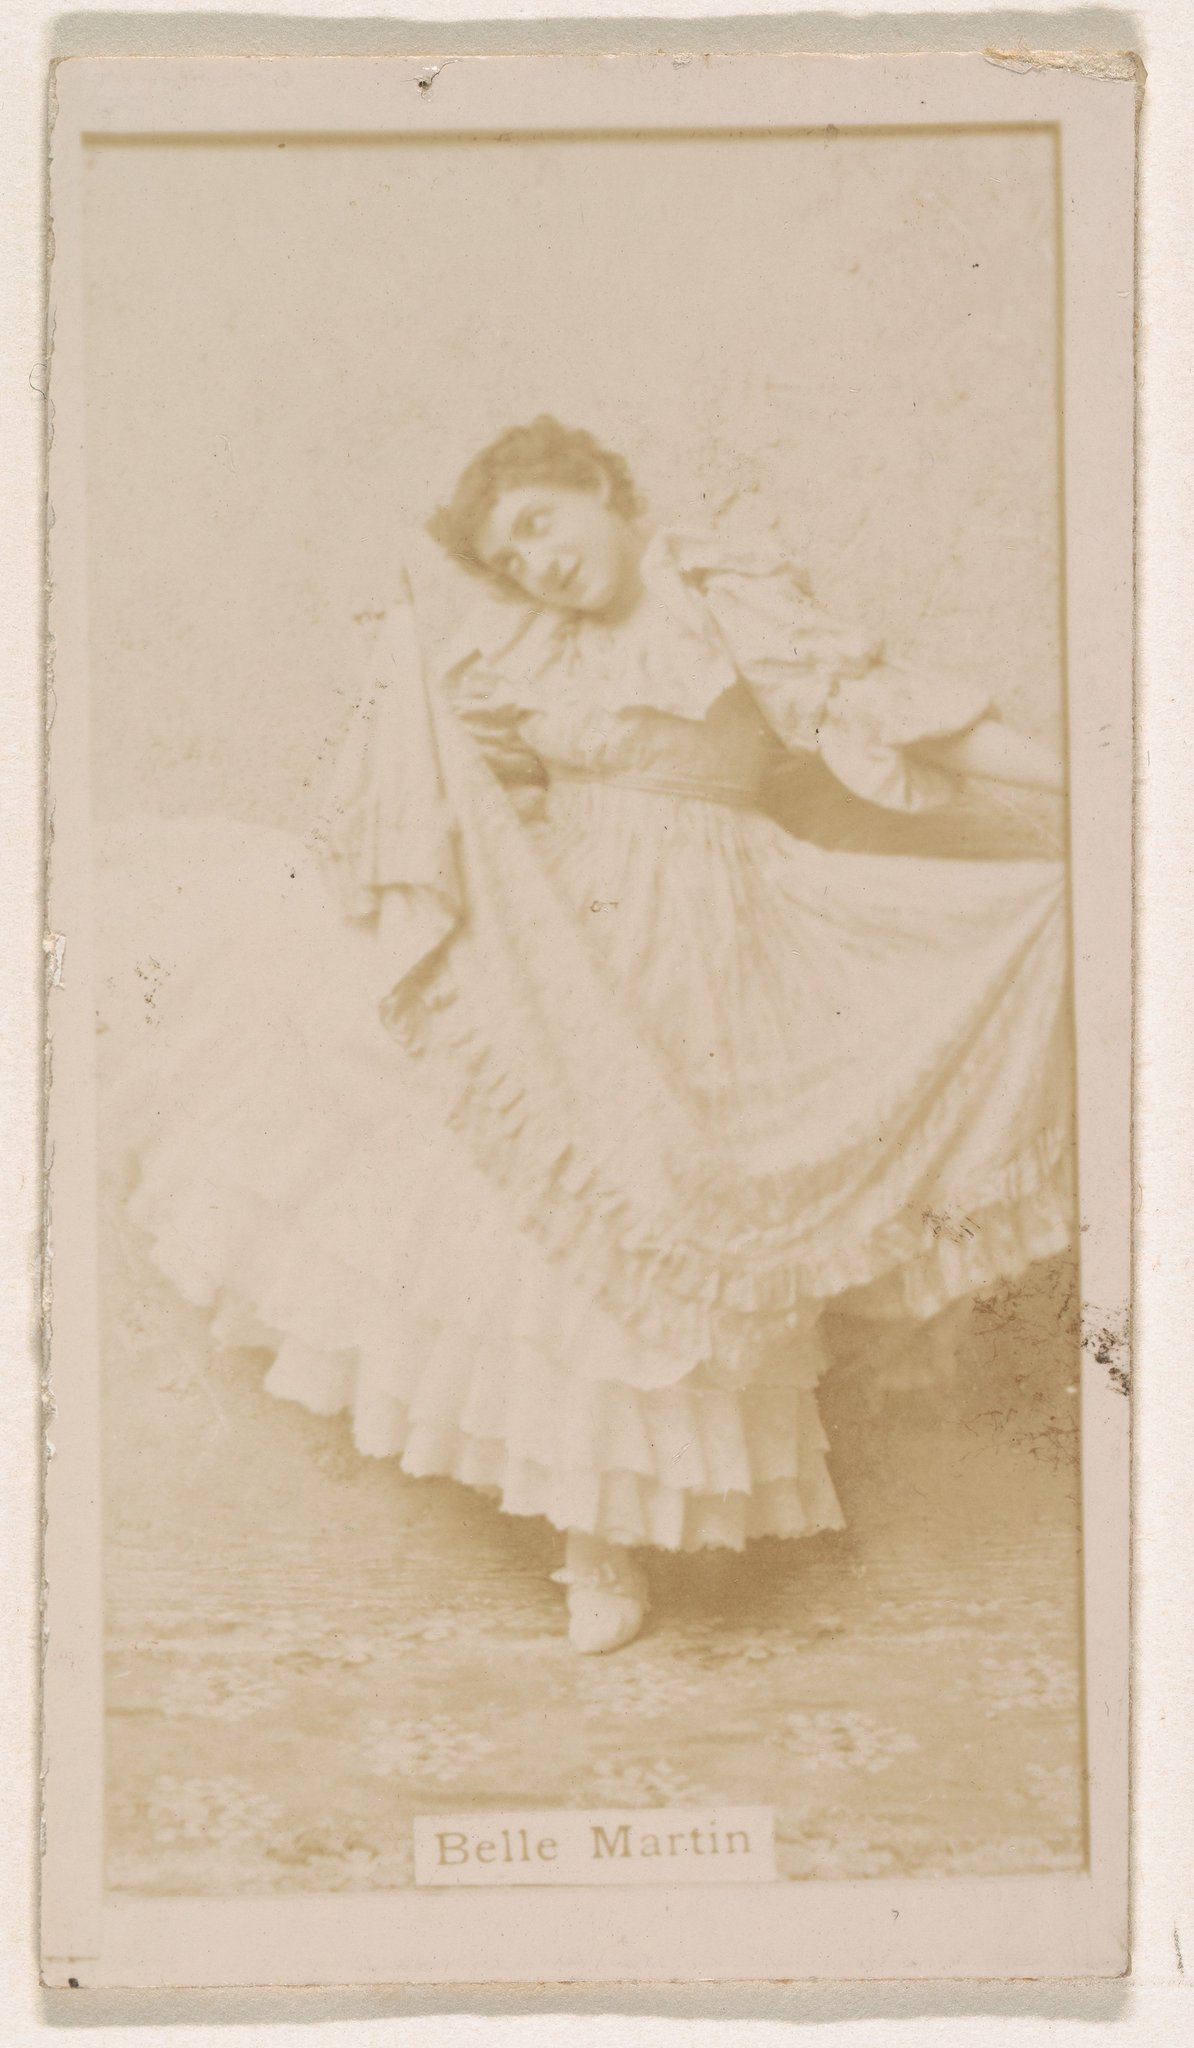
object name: photograph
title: Belle Martin, from the Actresses series (N245) issued by Kinney Brothers to promote Sweet Caporal Cigarettes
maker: kinney brothers tobacco company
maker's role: publisher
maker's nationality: american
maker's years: 1869-2011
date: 1890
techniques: albumen silver print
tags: portraits,women,actresses